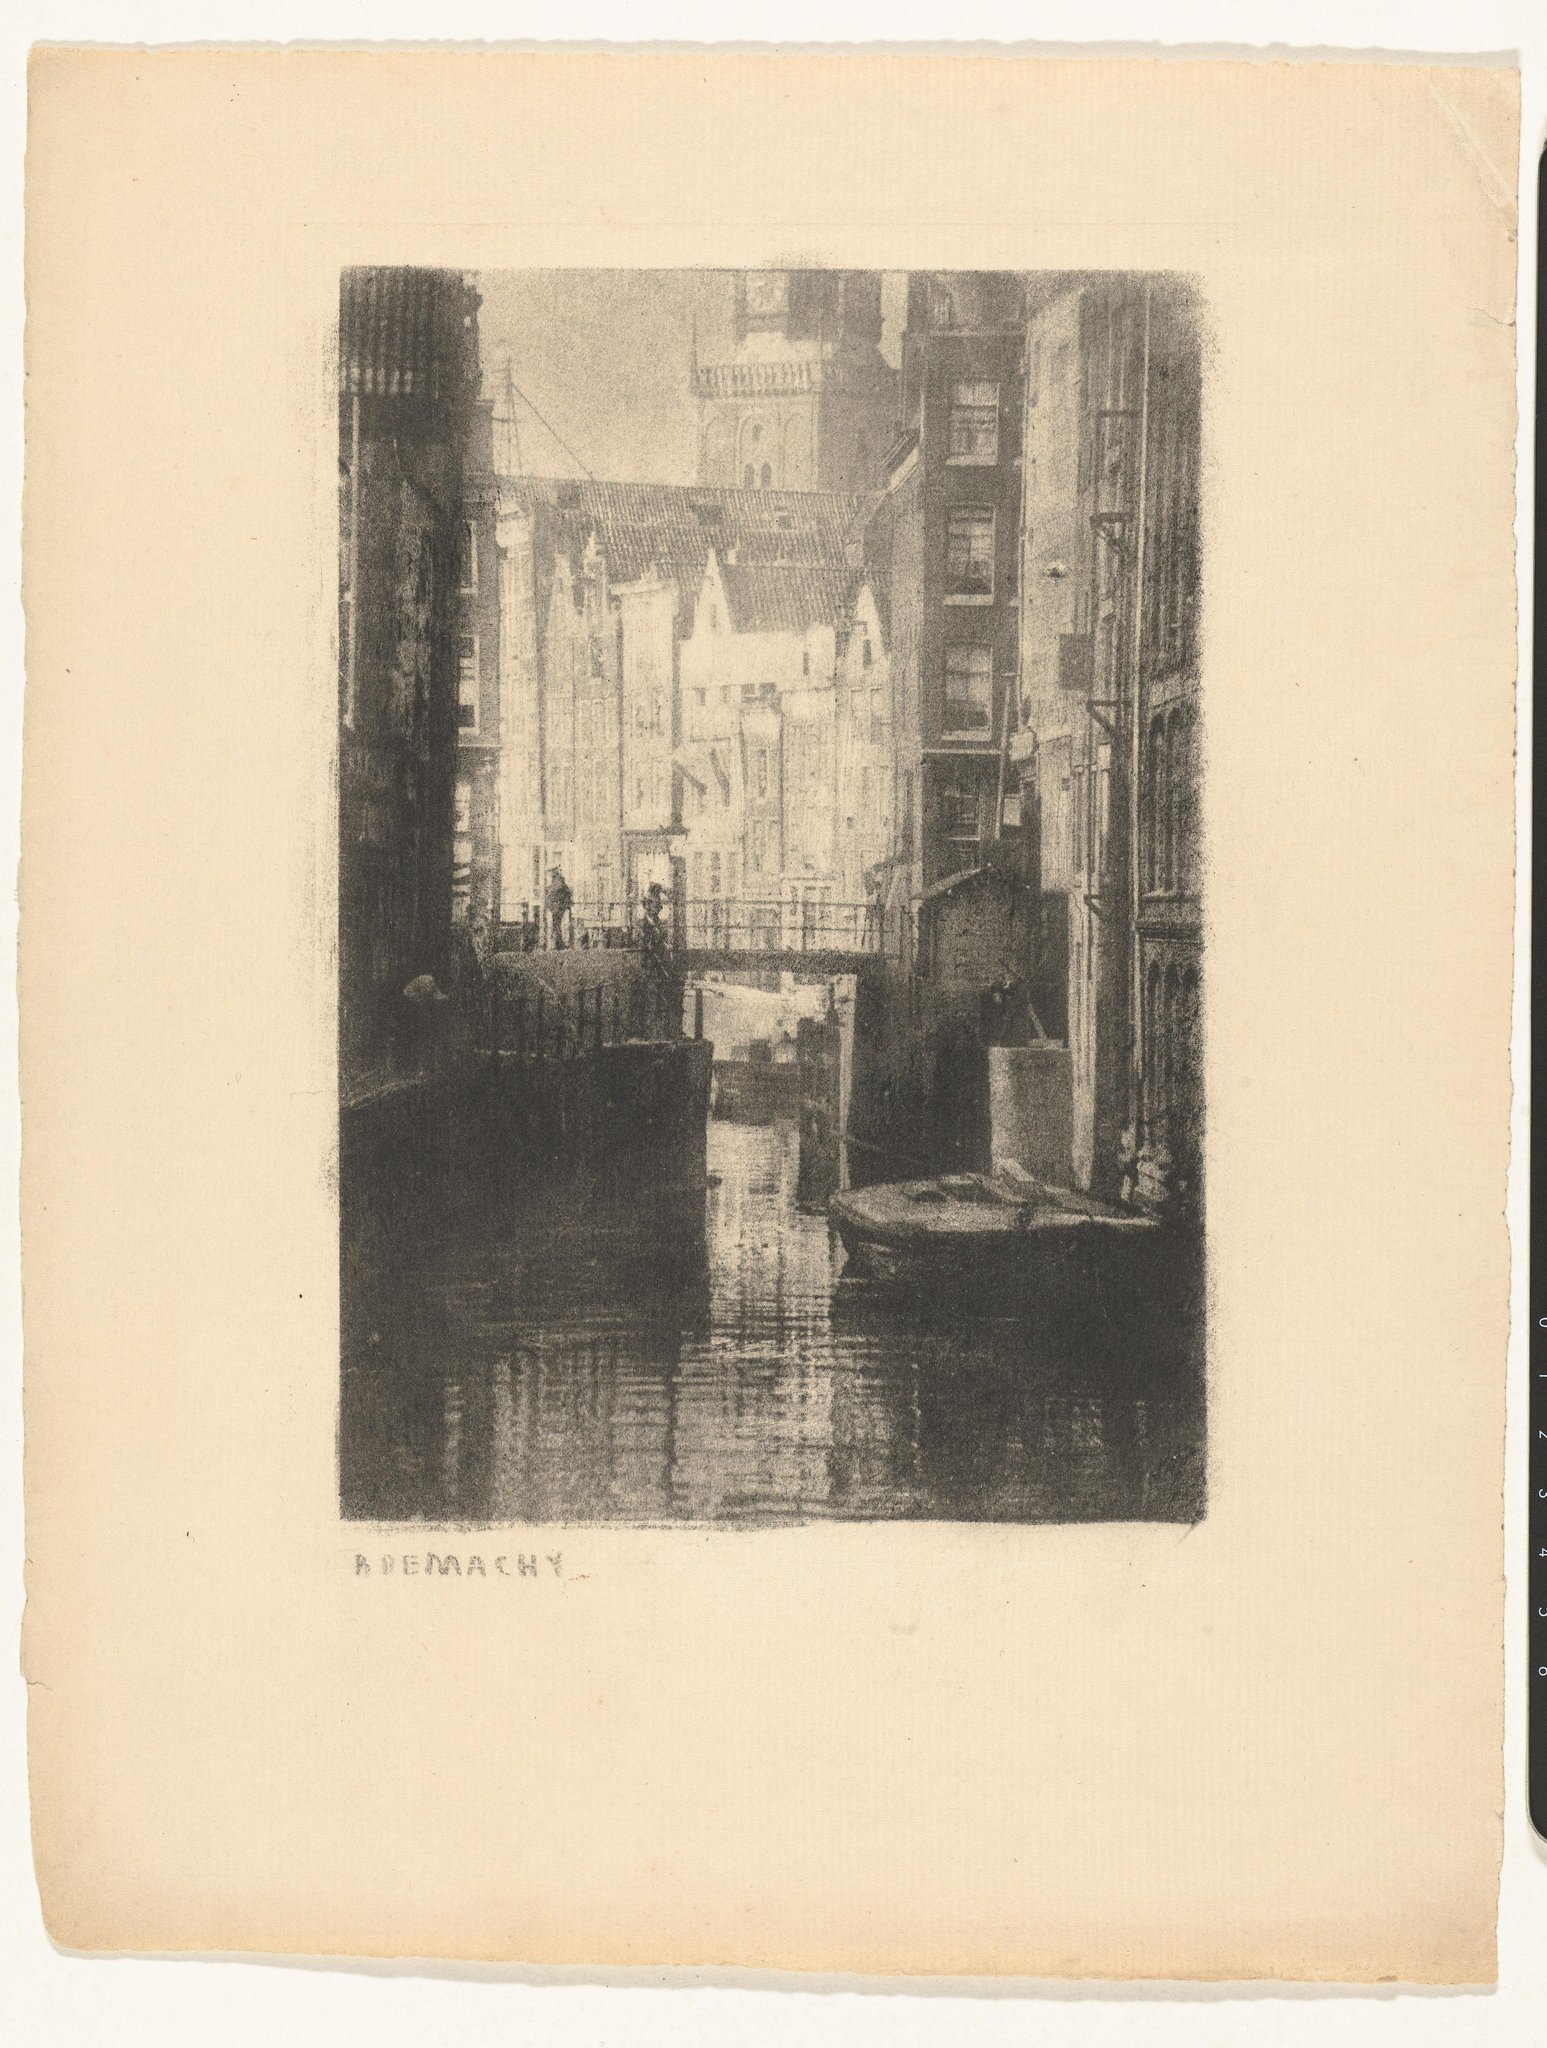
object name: photograph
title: View of the Kolkje Canal, Amsterdam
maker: robert demachy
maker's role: fotograaf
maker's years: 1859-1936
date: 1907-1914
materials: paper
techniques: oil transfer print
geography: amsterdam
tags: canals, waters (in city)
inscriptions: signature: ‘R Demachy’, inscription: ‘report’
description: Foreign Pictorialists considered ‘the Netherlands’ an exciting subject. With its windmills and waterways the landscape afforded endless possibilities. The reflective water of the canals in the cities also featured regularly in the work of photographers such as Alfred Stieglitz, James Craig Annan, and Alvin Langdon Coburn. The Frenchman Robert Demachy ventured into the Kolkje, a narrow canal in Amsterdam that was a famous tourist attraction already in the 19th century.